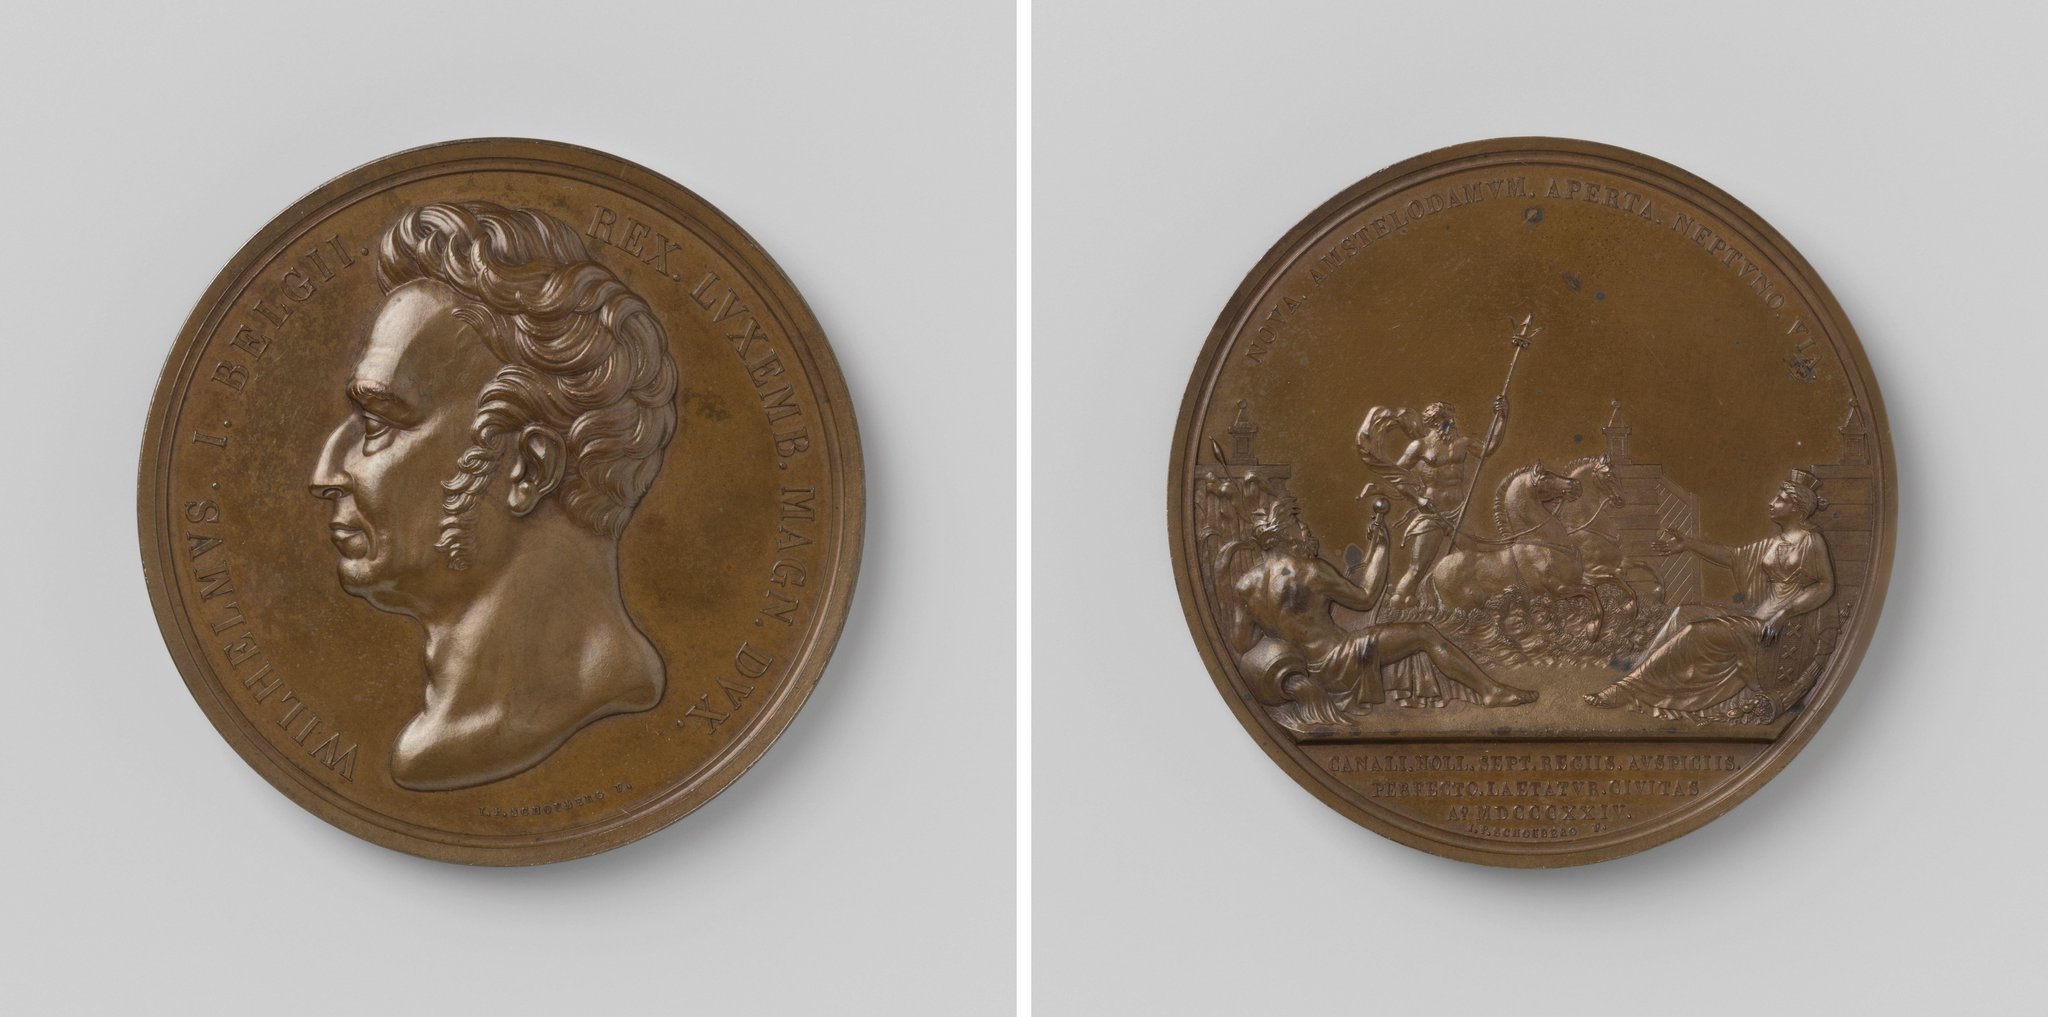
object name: history medal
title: Opening van het Noordhollandsch Kanaal, ter ere van Willem I Frederik, koning der Nederlanden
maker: johannis petrus schouberg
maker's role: die cutter, draughtsman, print maker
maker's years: 1798-1864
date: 1824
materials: bronze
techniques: striking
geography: utrecht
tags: the hague, berlin, william i of the netherlands